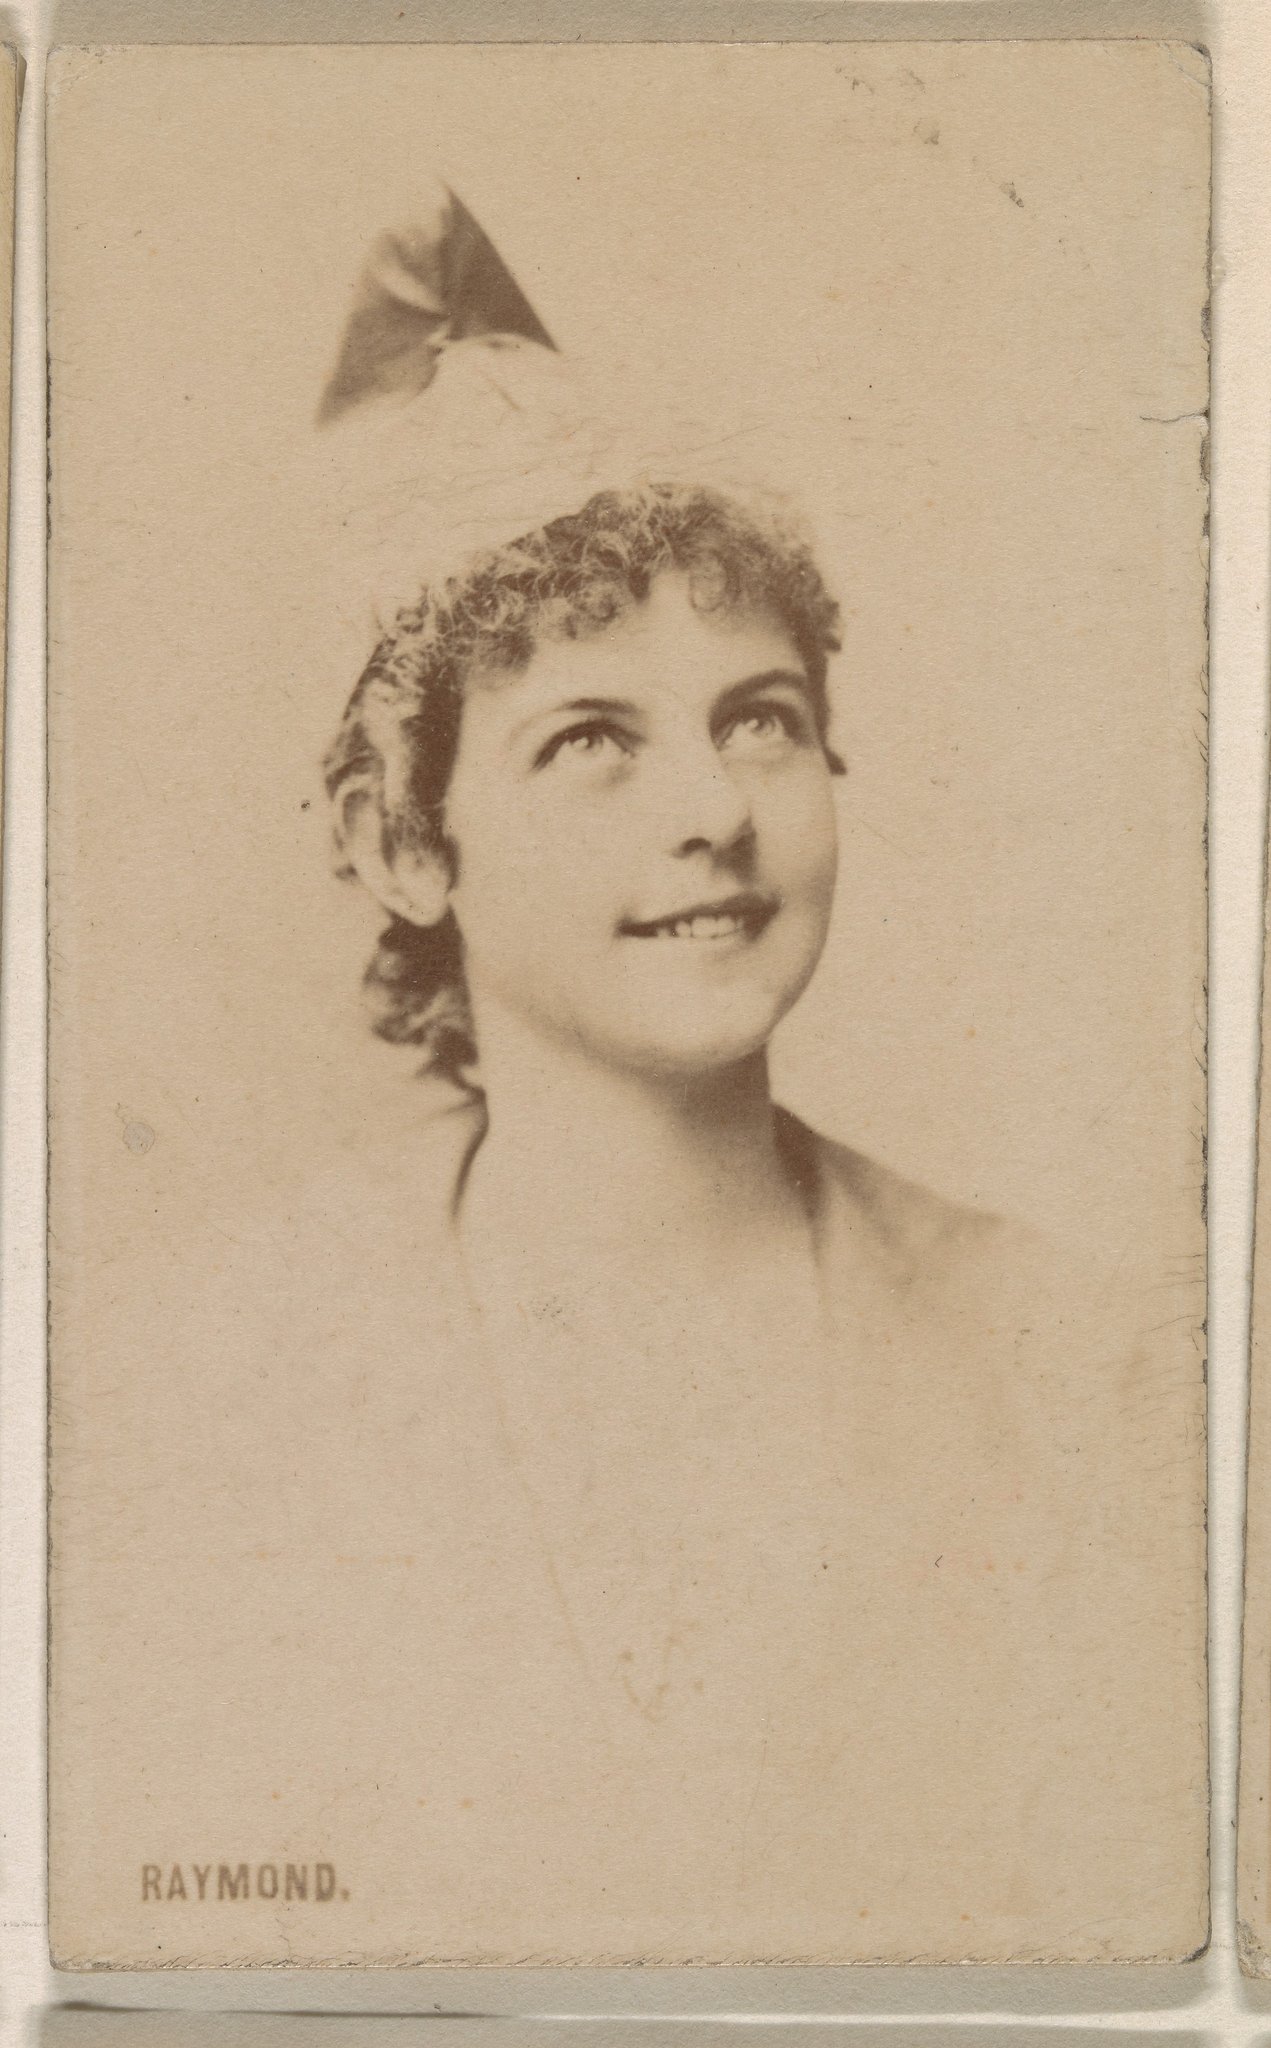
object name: photograph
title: Miss Raymond, from the Actresses series (N246), Type 1, issued by Kinney Brothers to promote Sporting Extra Cigarettes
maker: kinney brothers tobacco company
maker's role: publisher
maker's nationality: american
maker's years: 1869-2011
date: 1890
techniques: albumen silver print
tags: portraits,women,actresses